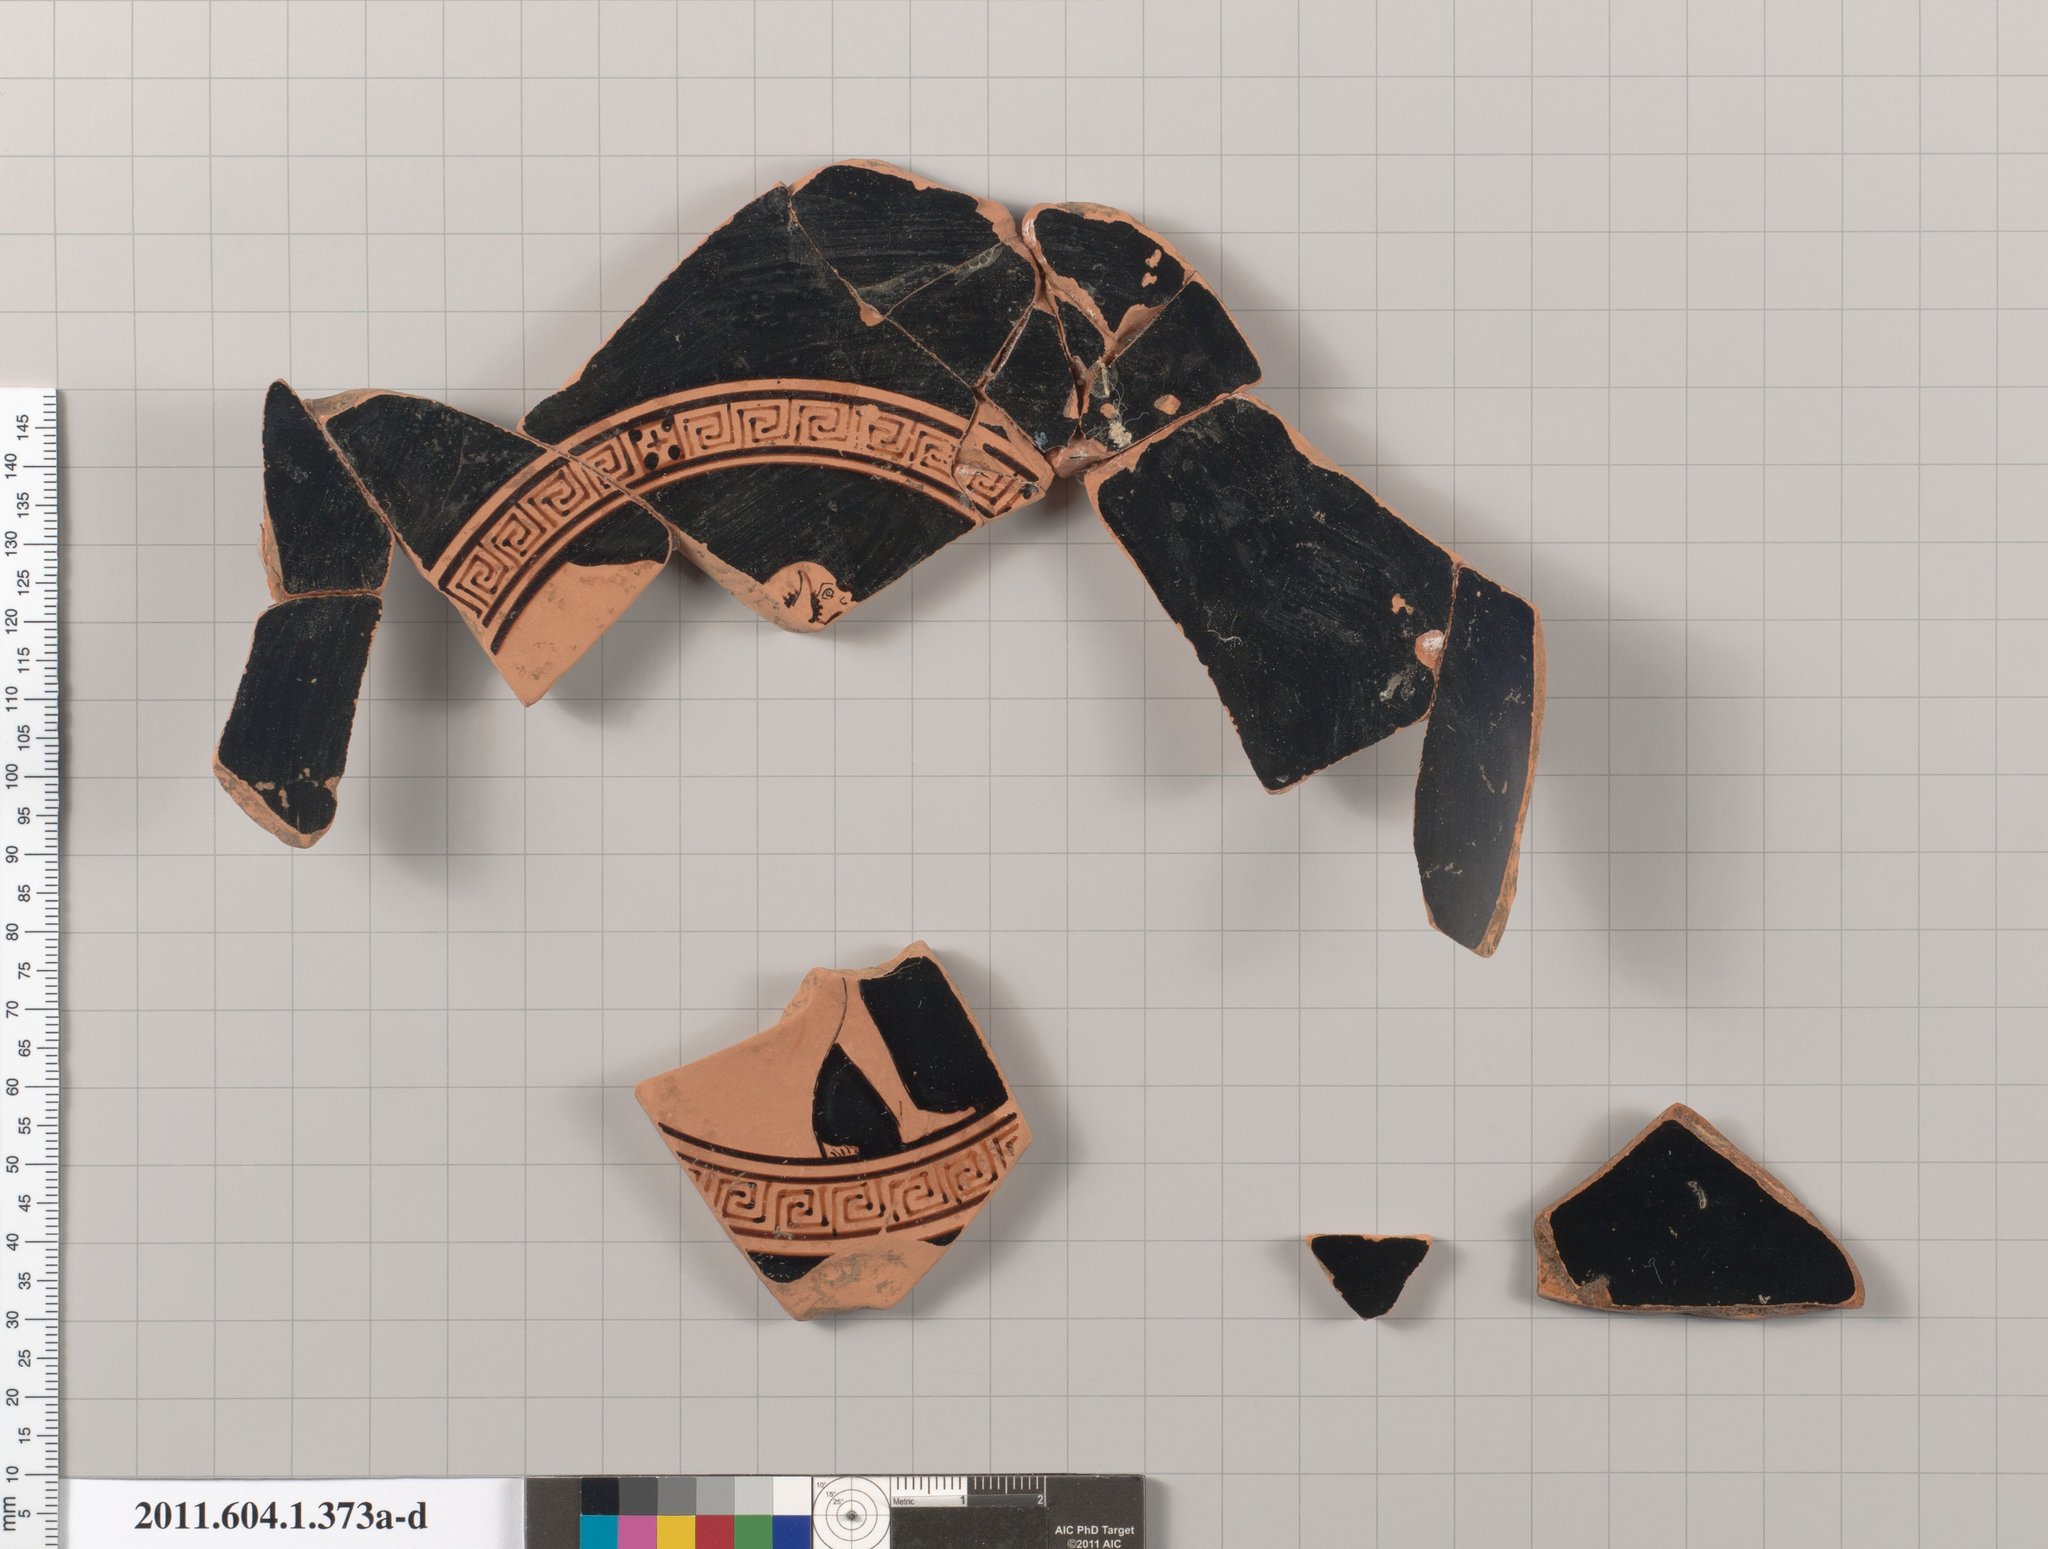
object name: kylix fragment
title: Terracotta fragments of a kylix (drinking cup)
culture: greek, attic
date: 467-435 BCE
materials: terracotta